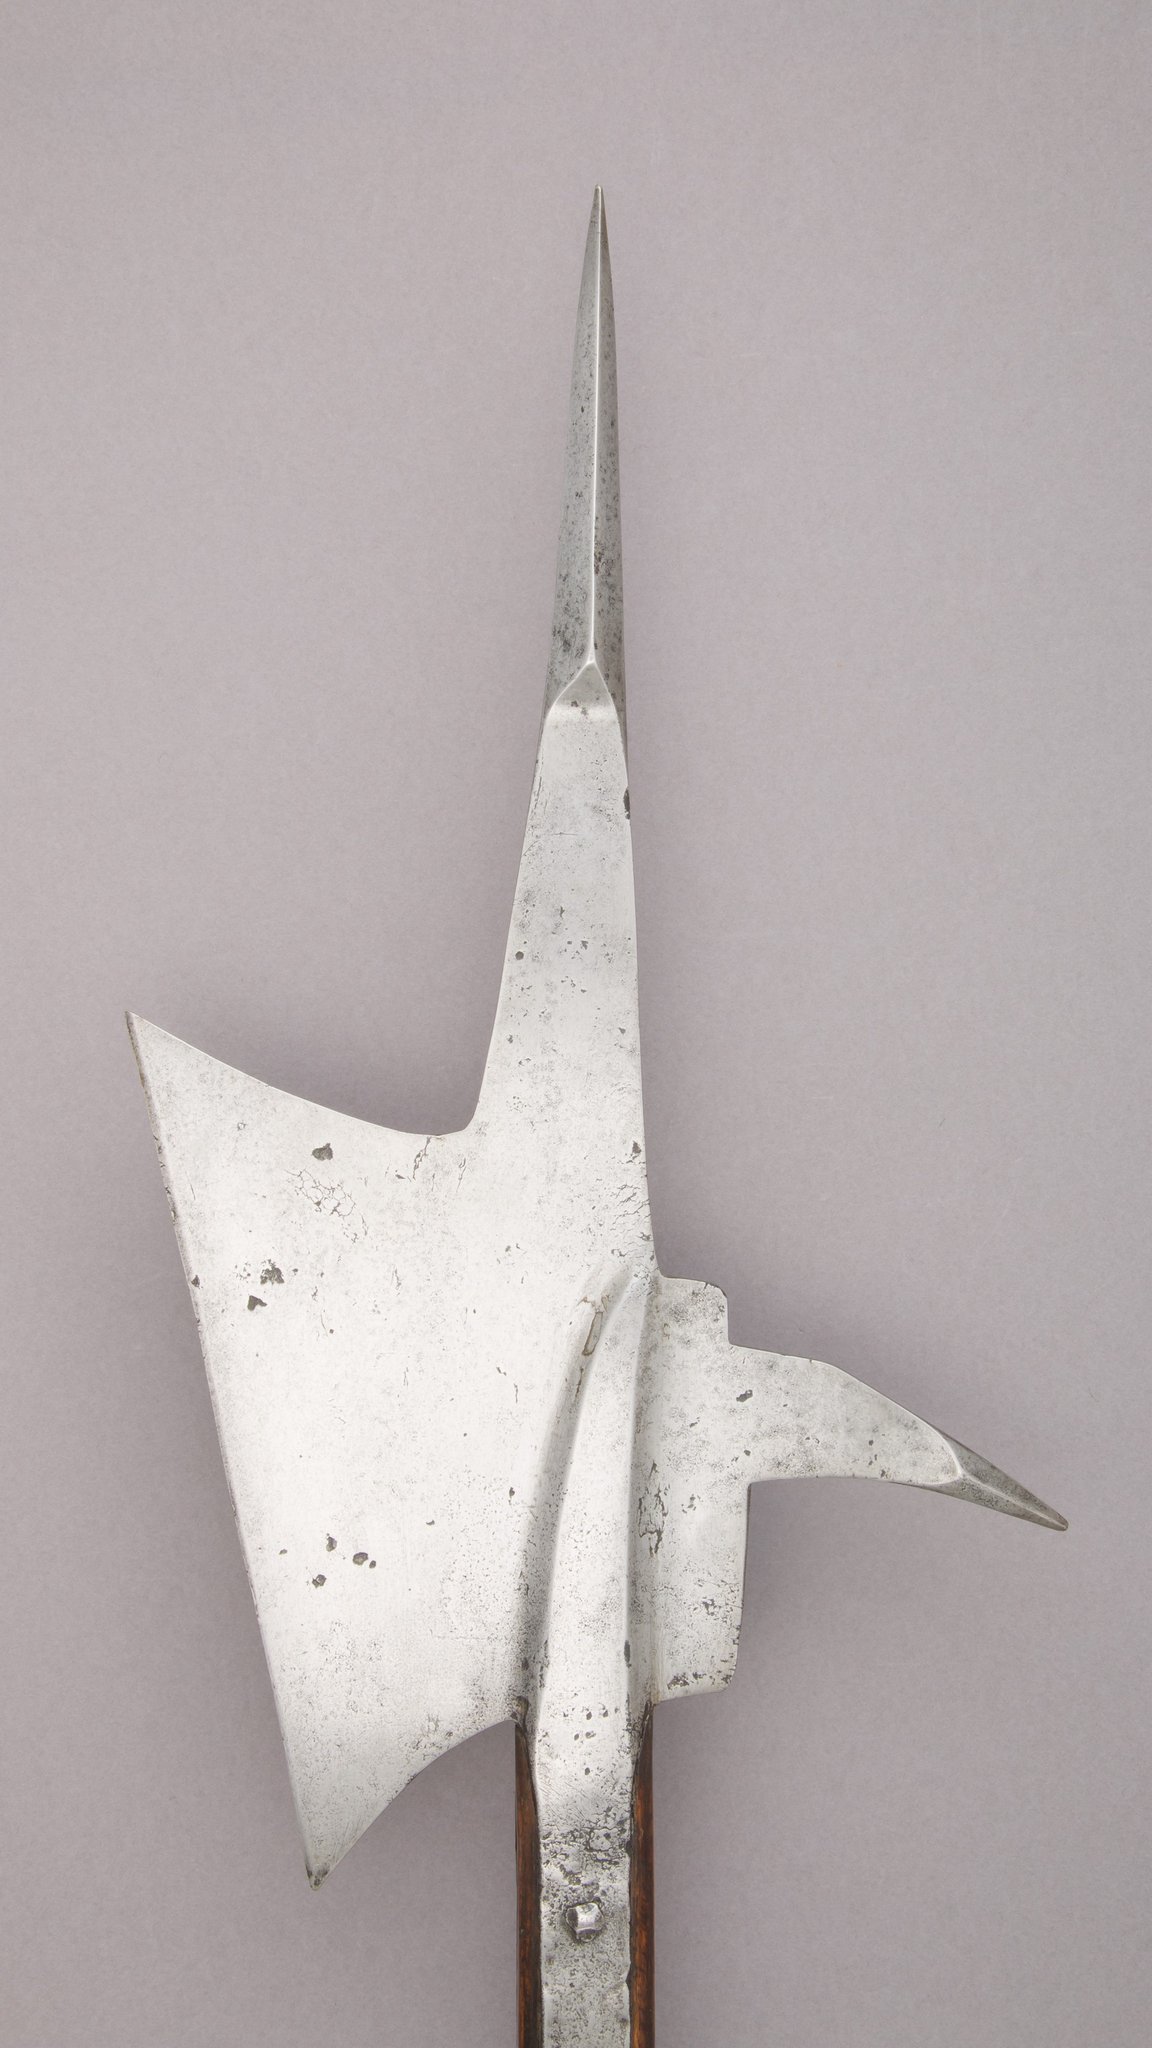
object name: halberd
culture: swiss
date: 1510-1520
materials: steel, wood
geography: switzerland